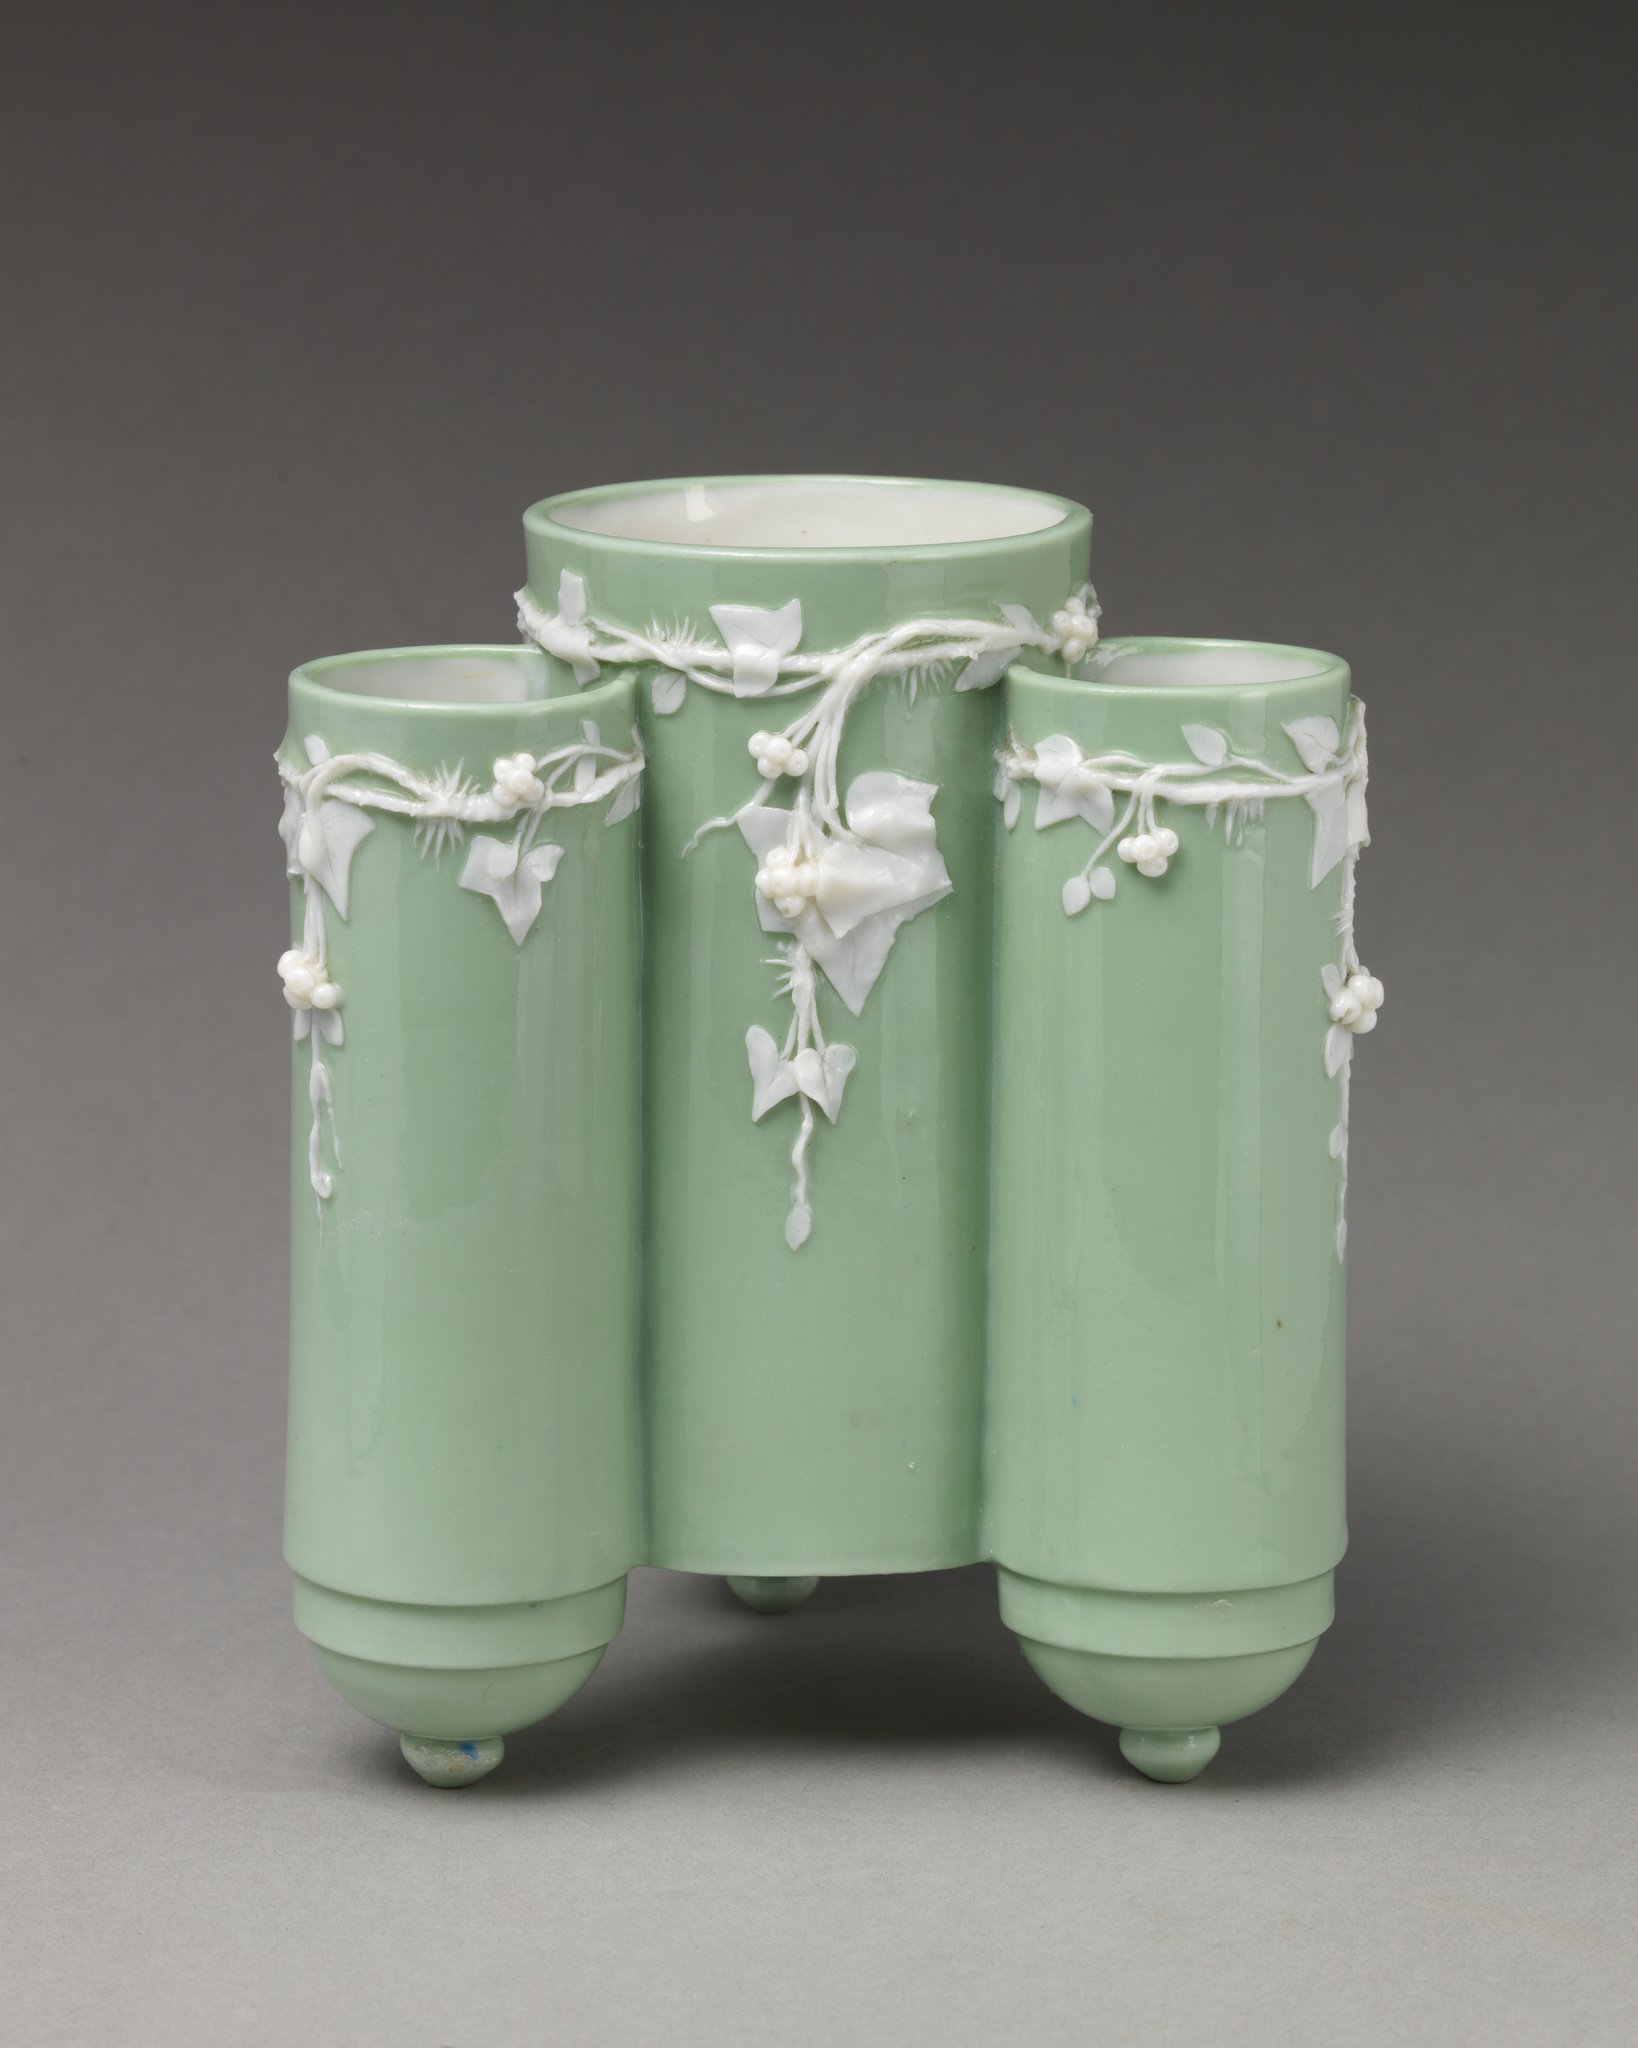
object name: vase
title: Triple cylindrical body vase with ivy motif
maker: minton(s)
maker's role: maker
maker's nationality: british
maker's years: 1793-2001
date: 1870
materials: bone china